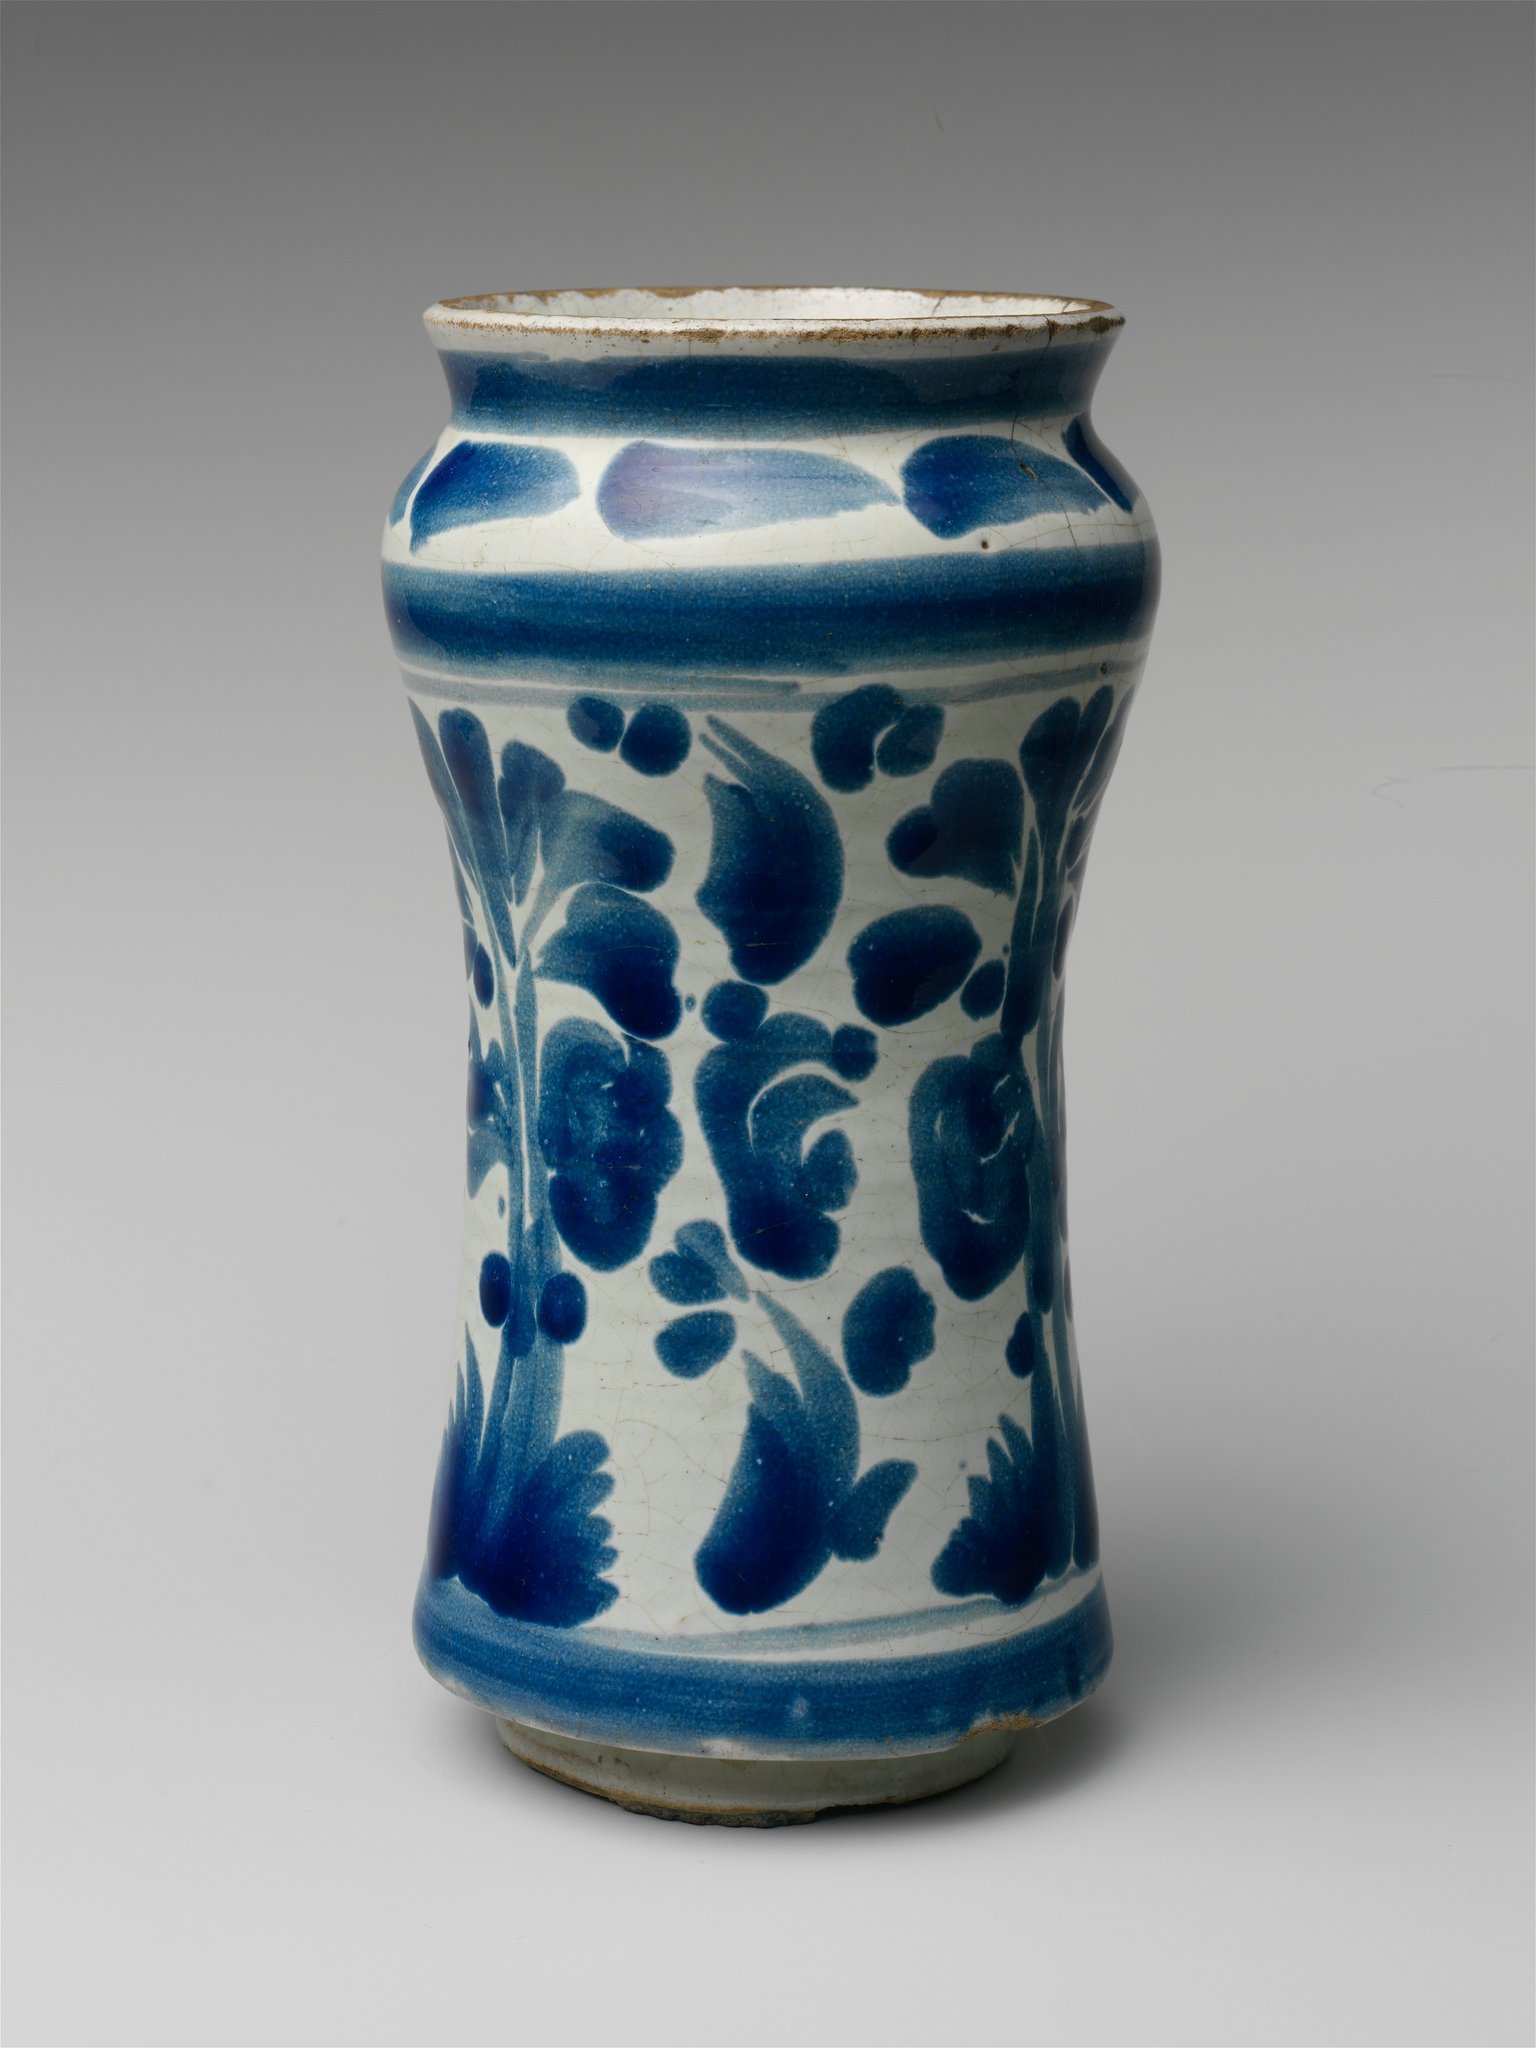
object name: apothecary jar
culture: mexican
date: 1800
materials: earthenware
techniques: glazing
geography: mexico